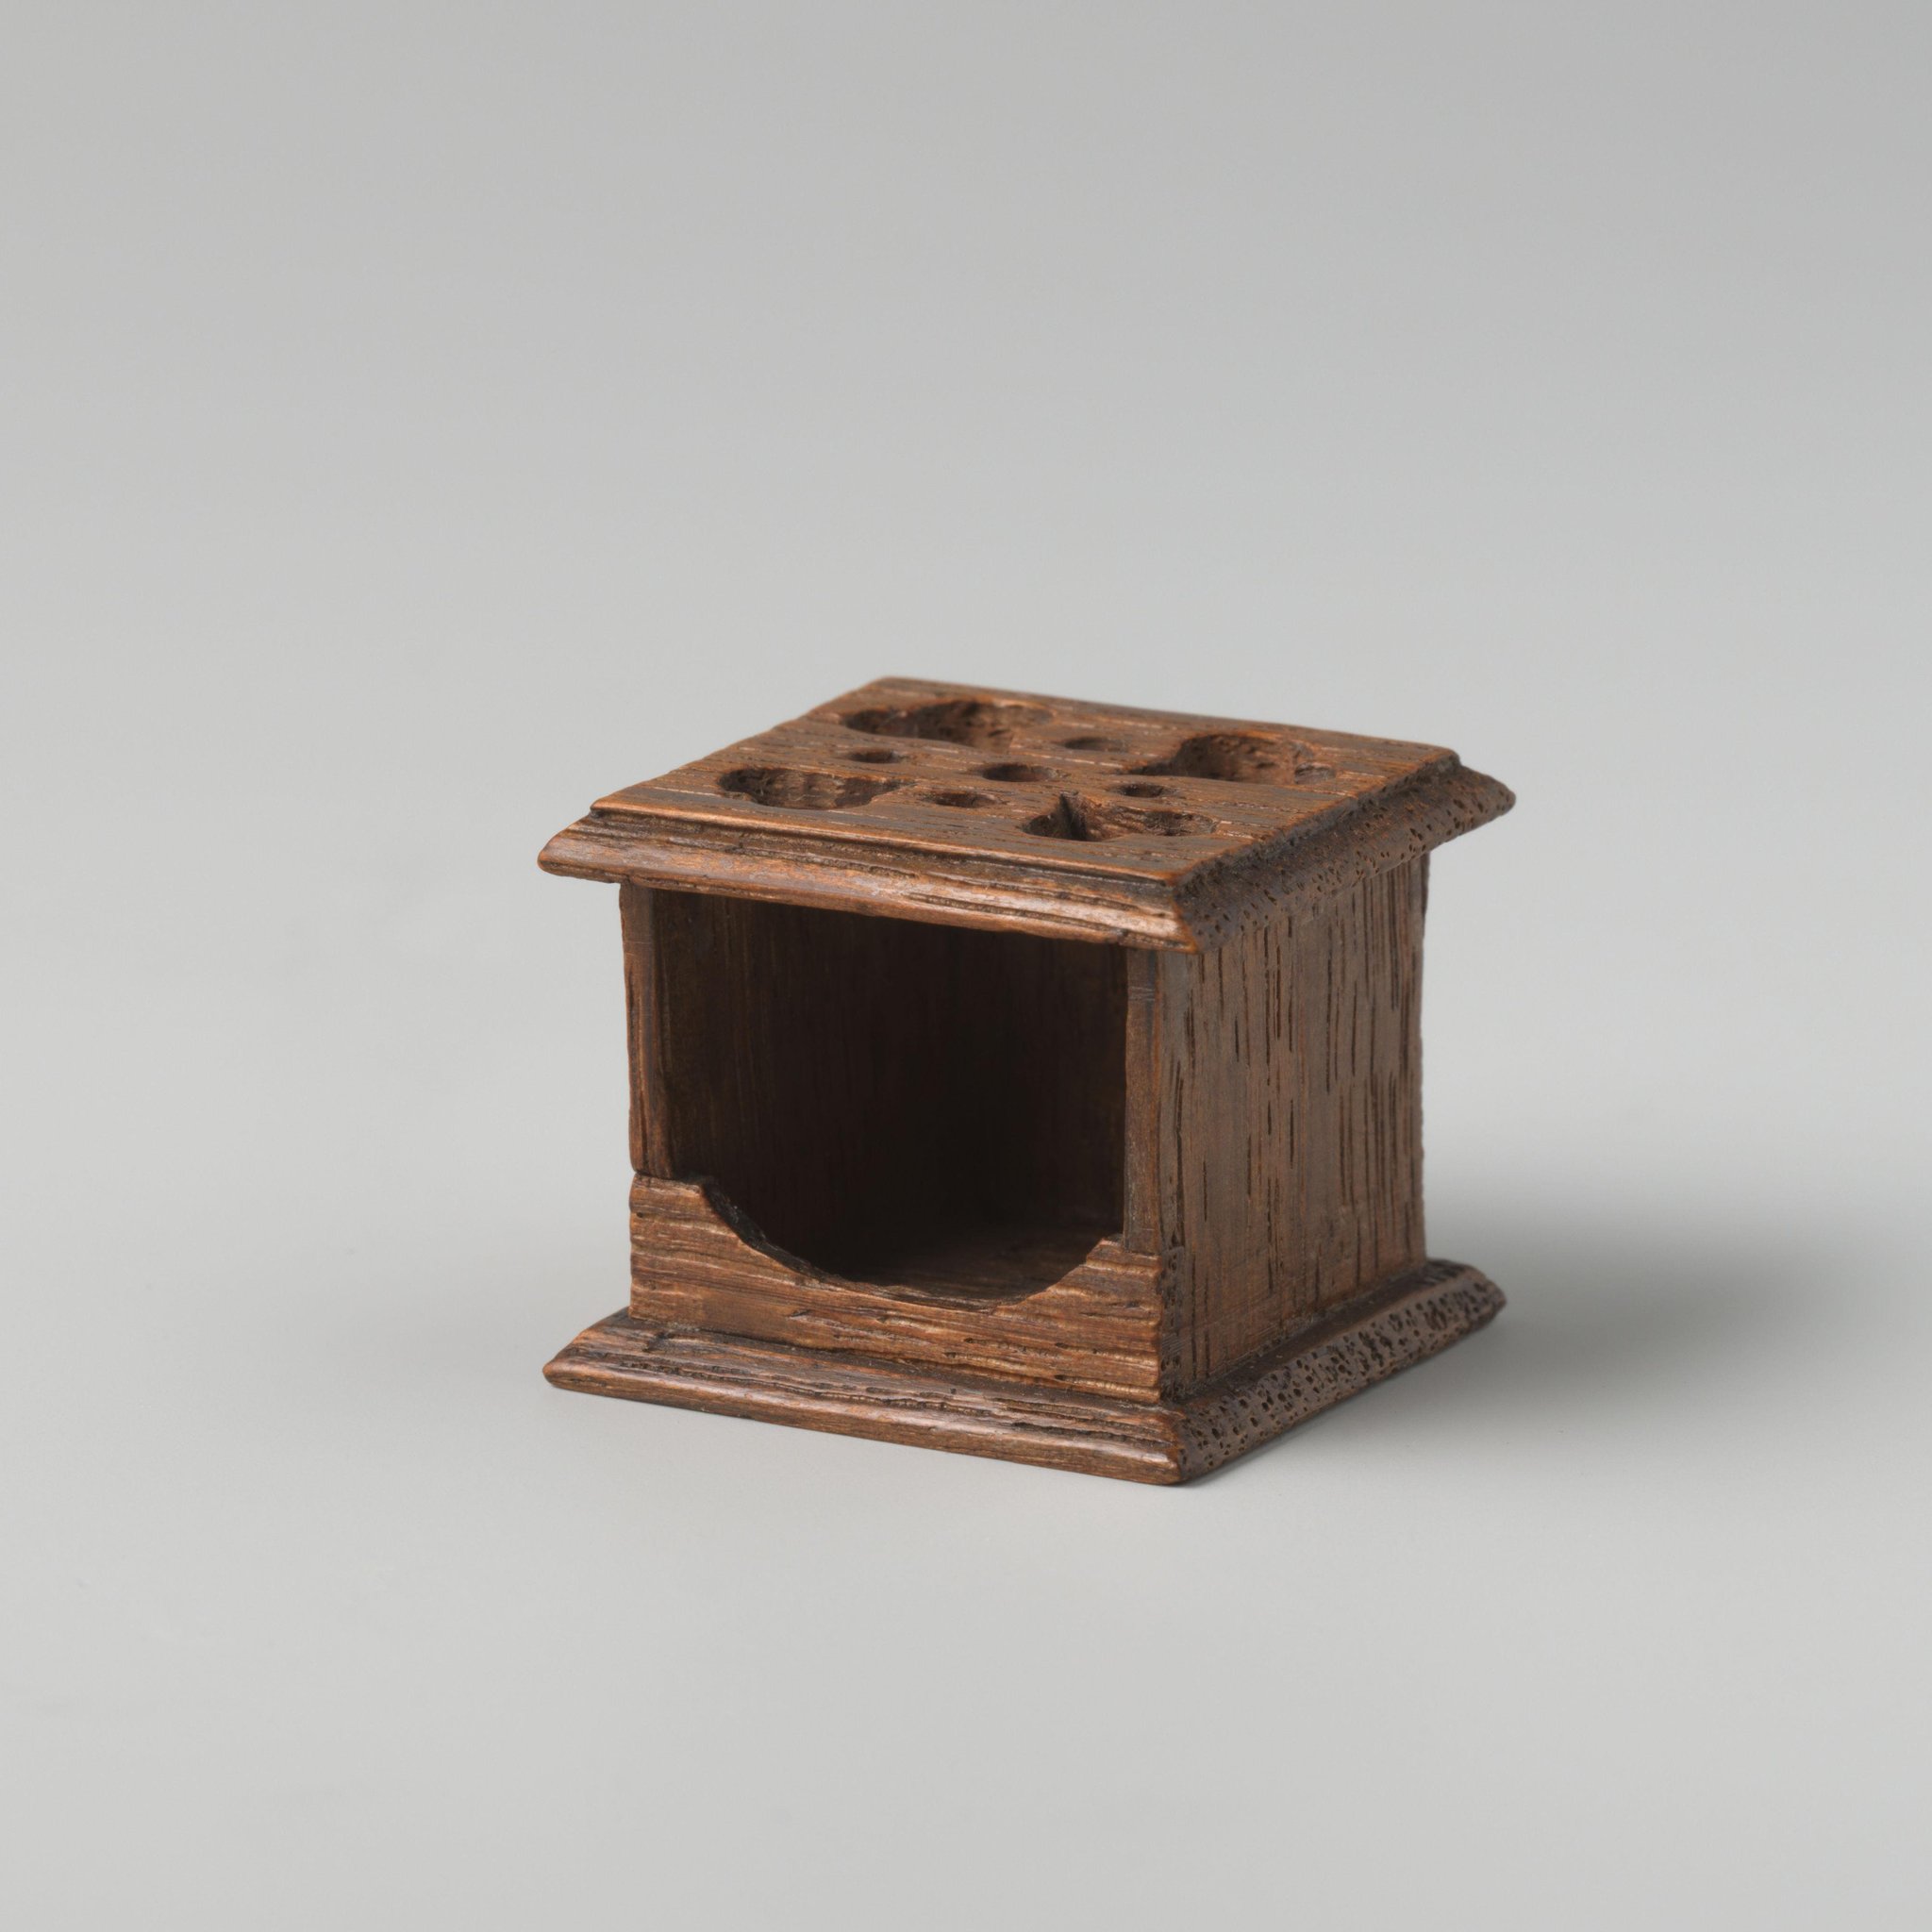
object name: voetstoof, stoof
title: Vierkante stoof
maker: Anonymous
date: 1690-1710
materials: wood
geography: amsterdam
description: Vierkante stoof van eikenhout. De stoof heeft een opstaande rand aan de voorzijde en in de voetenplank zijn vier hartvormige en vijf ronde gaten aangebracht.